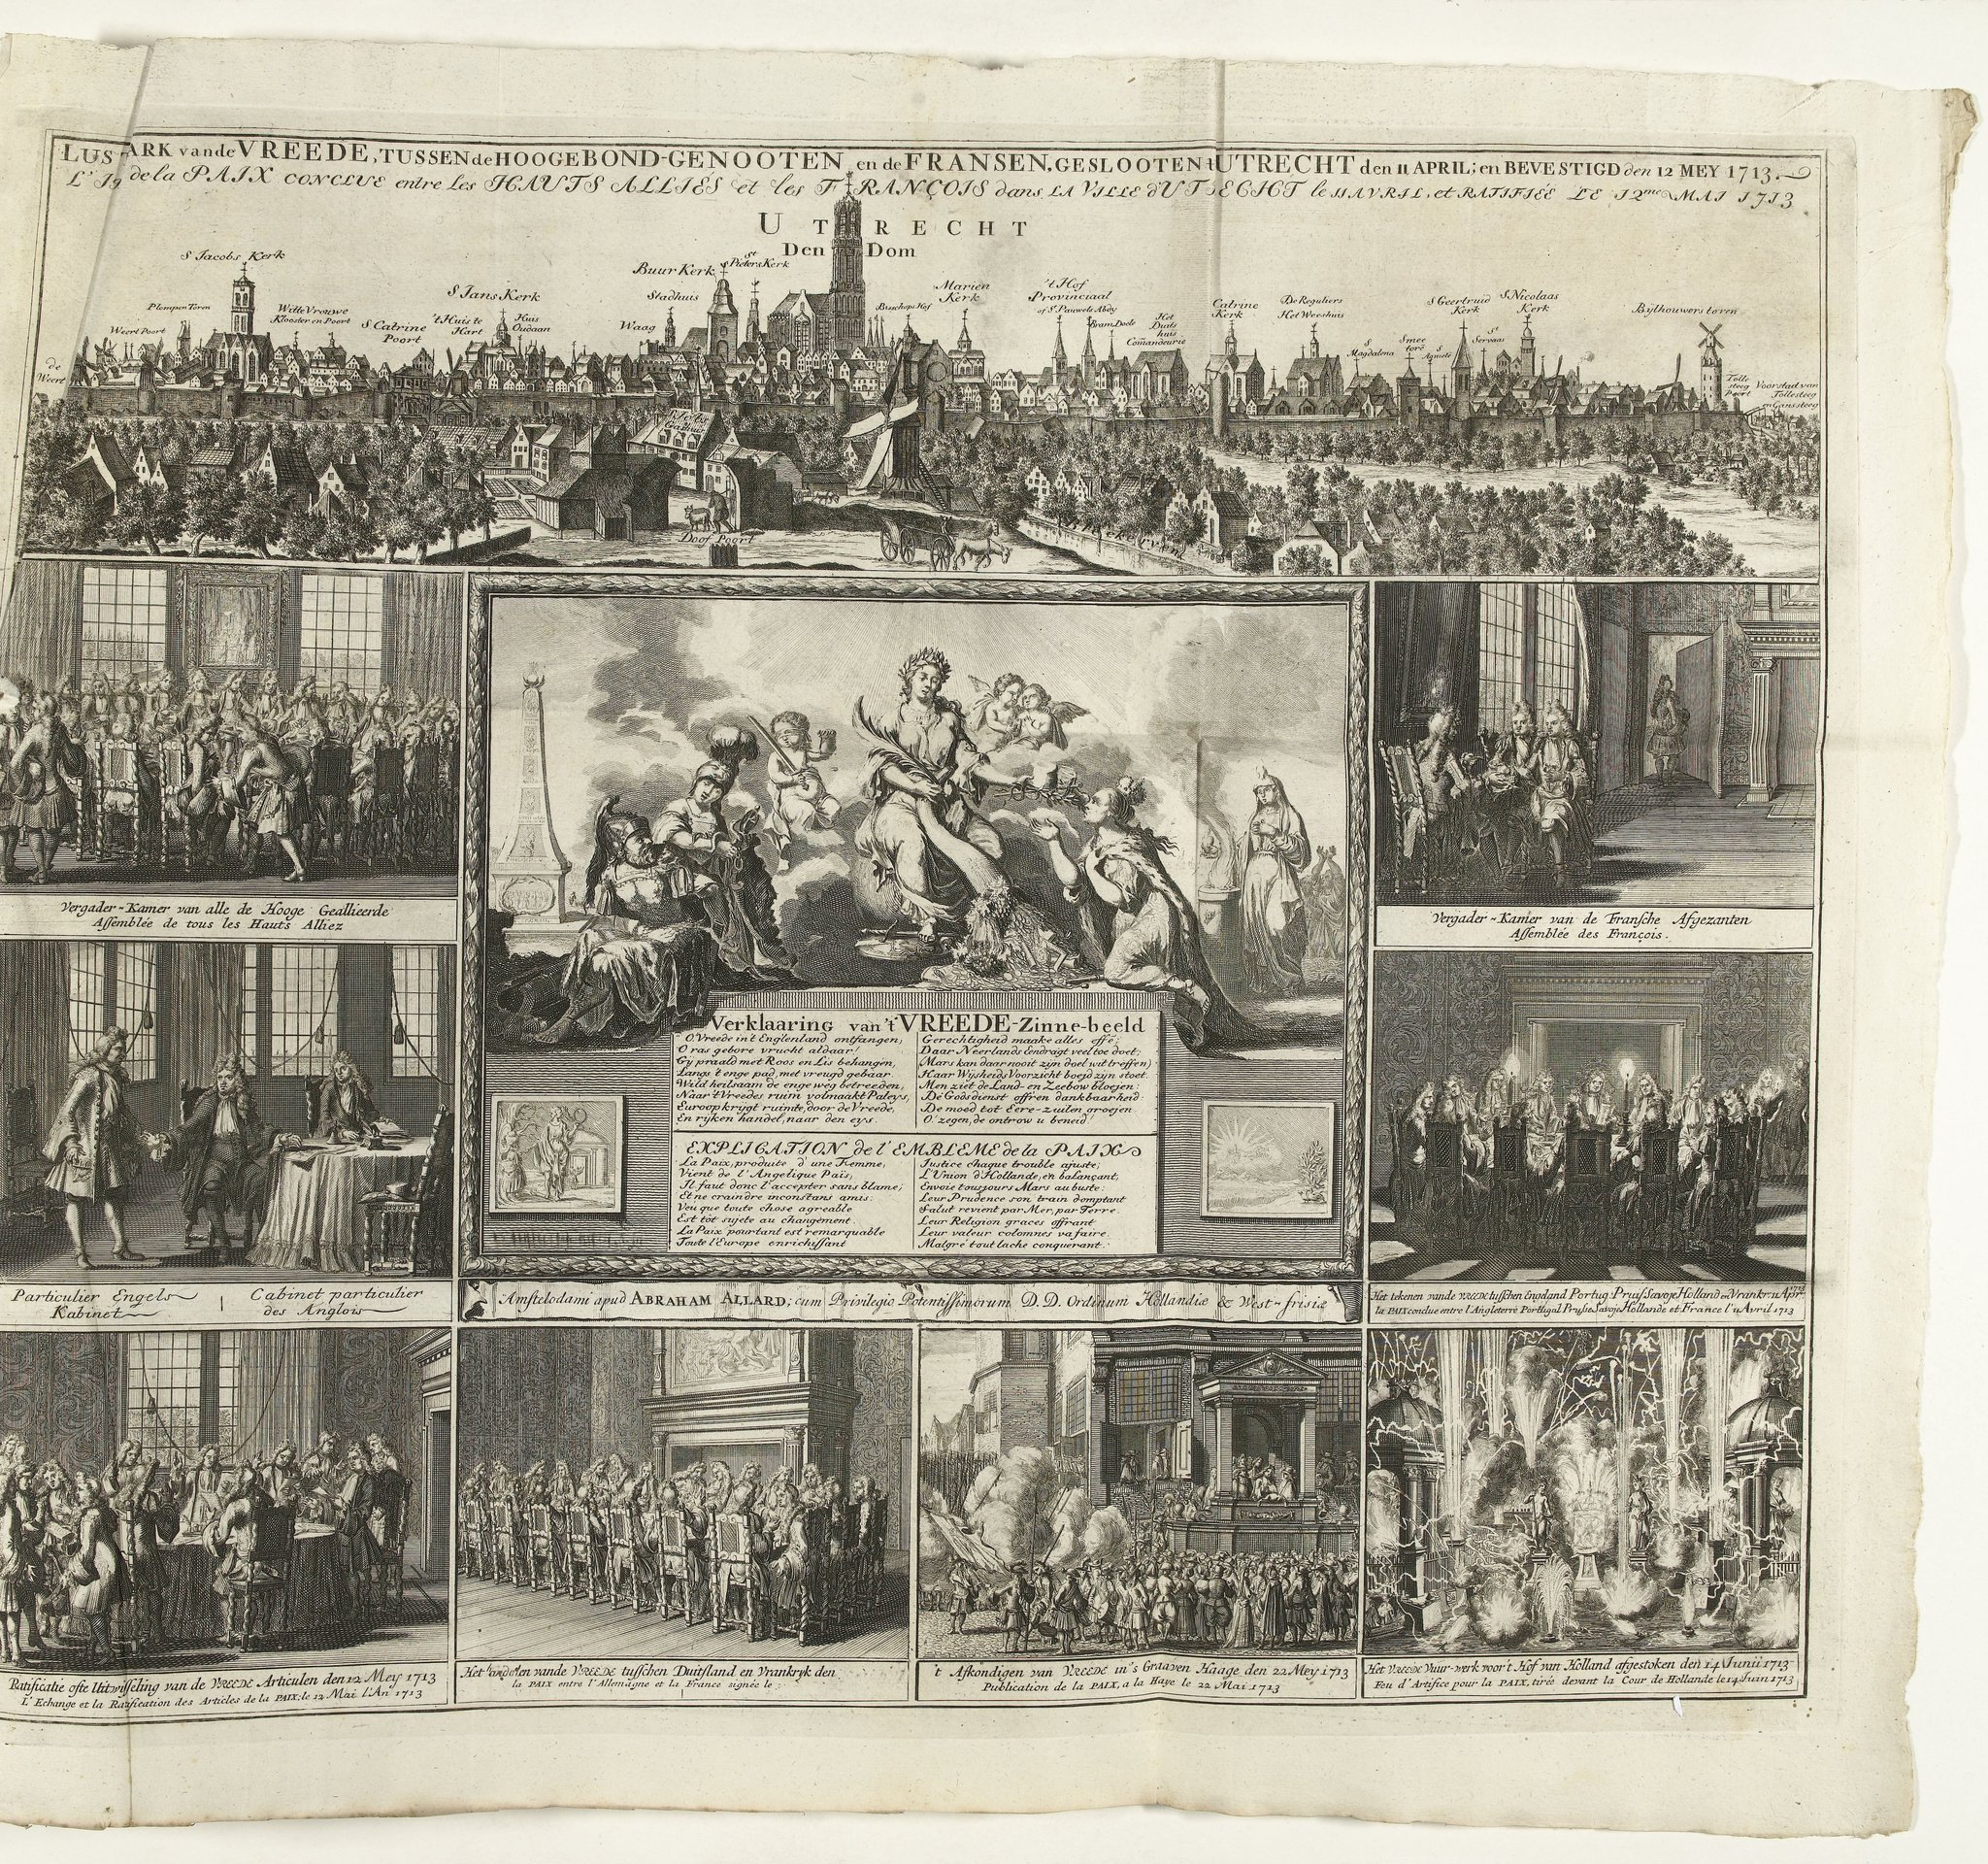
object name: print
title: Les Principales Forteresses & Villes Fortes, d'Espagne, de France, d'Italie, de Savoië, d'Allemagne & des Païs-Bas (...) / Naaukeurige Afbeeldingen der Voornaamste Sterke Steden en Vestingen in Spanjen, Vrankryk, Italien, Savoyen, Duytsland en Nederlanden (...)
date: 1697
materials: paper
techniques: etching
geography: leiden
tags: symbols, allegories of peace, 'pax'; 'pace' (ripa), peace negotiations, proclamation of peace, bonfire, fire-works, festivities (+ illumination, fire-works ~ festive activities), signing of peace treaty, concluding the peace, utrecht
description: De Vrede van Utrecht, gesloten op 11 april en geratificeerd op 12 mei 1713, tussen de geallieerden en de Fransen, waarmee een eind kwam aan de Spaanse Successieoorlog. Groot blad met bovenaan een gezicht op Utrecht en centraal een allegorie op de Vrede. Omringd door acht kleinere scènes van de vredesonderhandelingen en het vuurwerk bij de viering van de vrede afgestoken te Den Haag op 14 juni 1713. Onderdeel van de gebundelde reeks van 49 platen van vermaarde sterke steden en vestingen in de Spaanse Successieoorlog, ca. 1701-1713. Met de titels in het Nederlands en Frans.